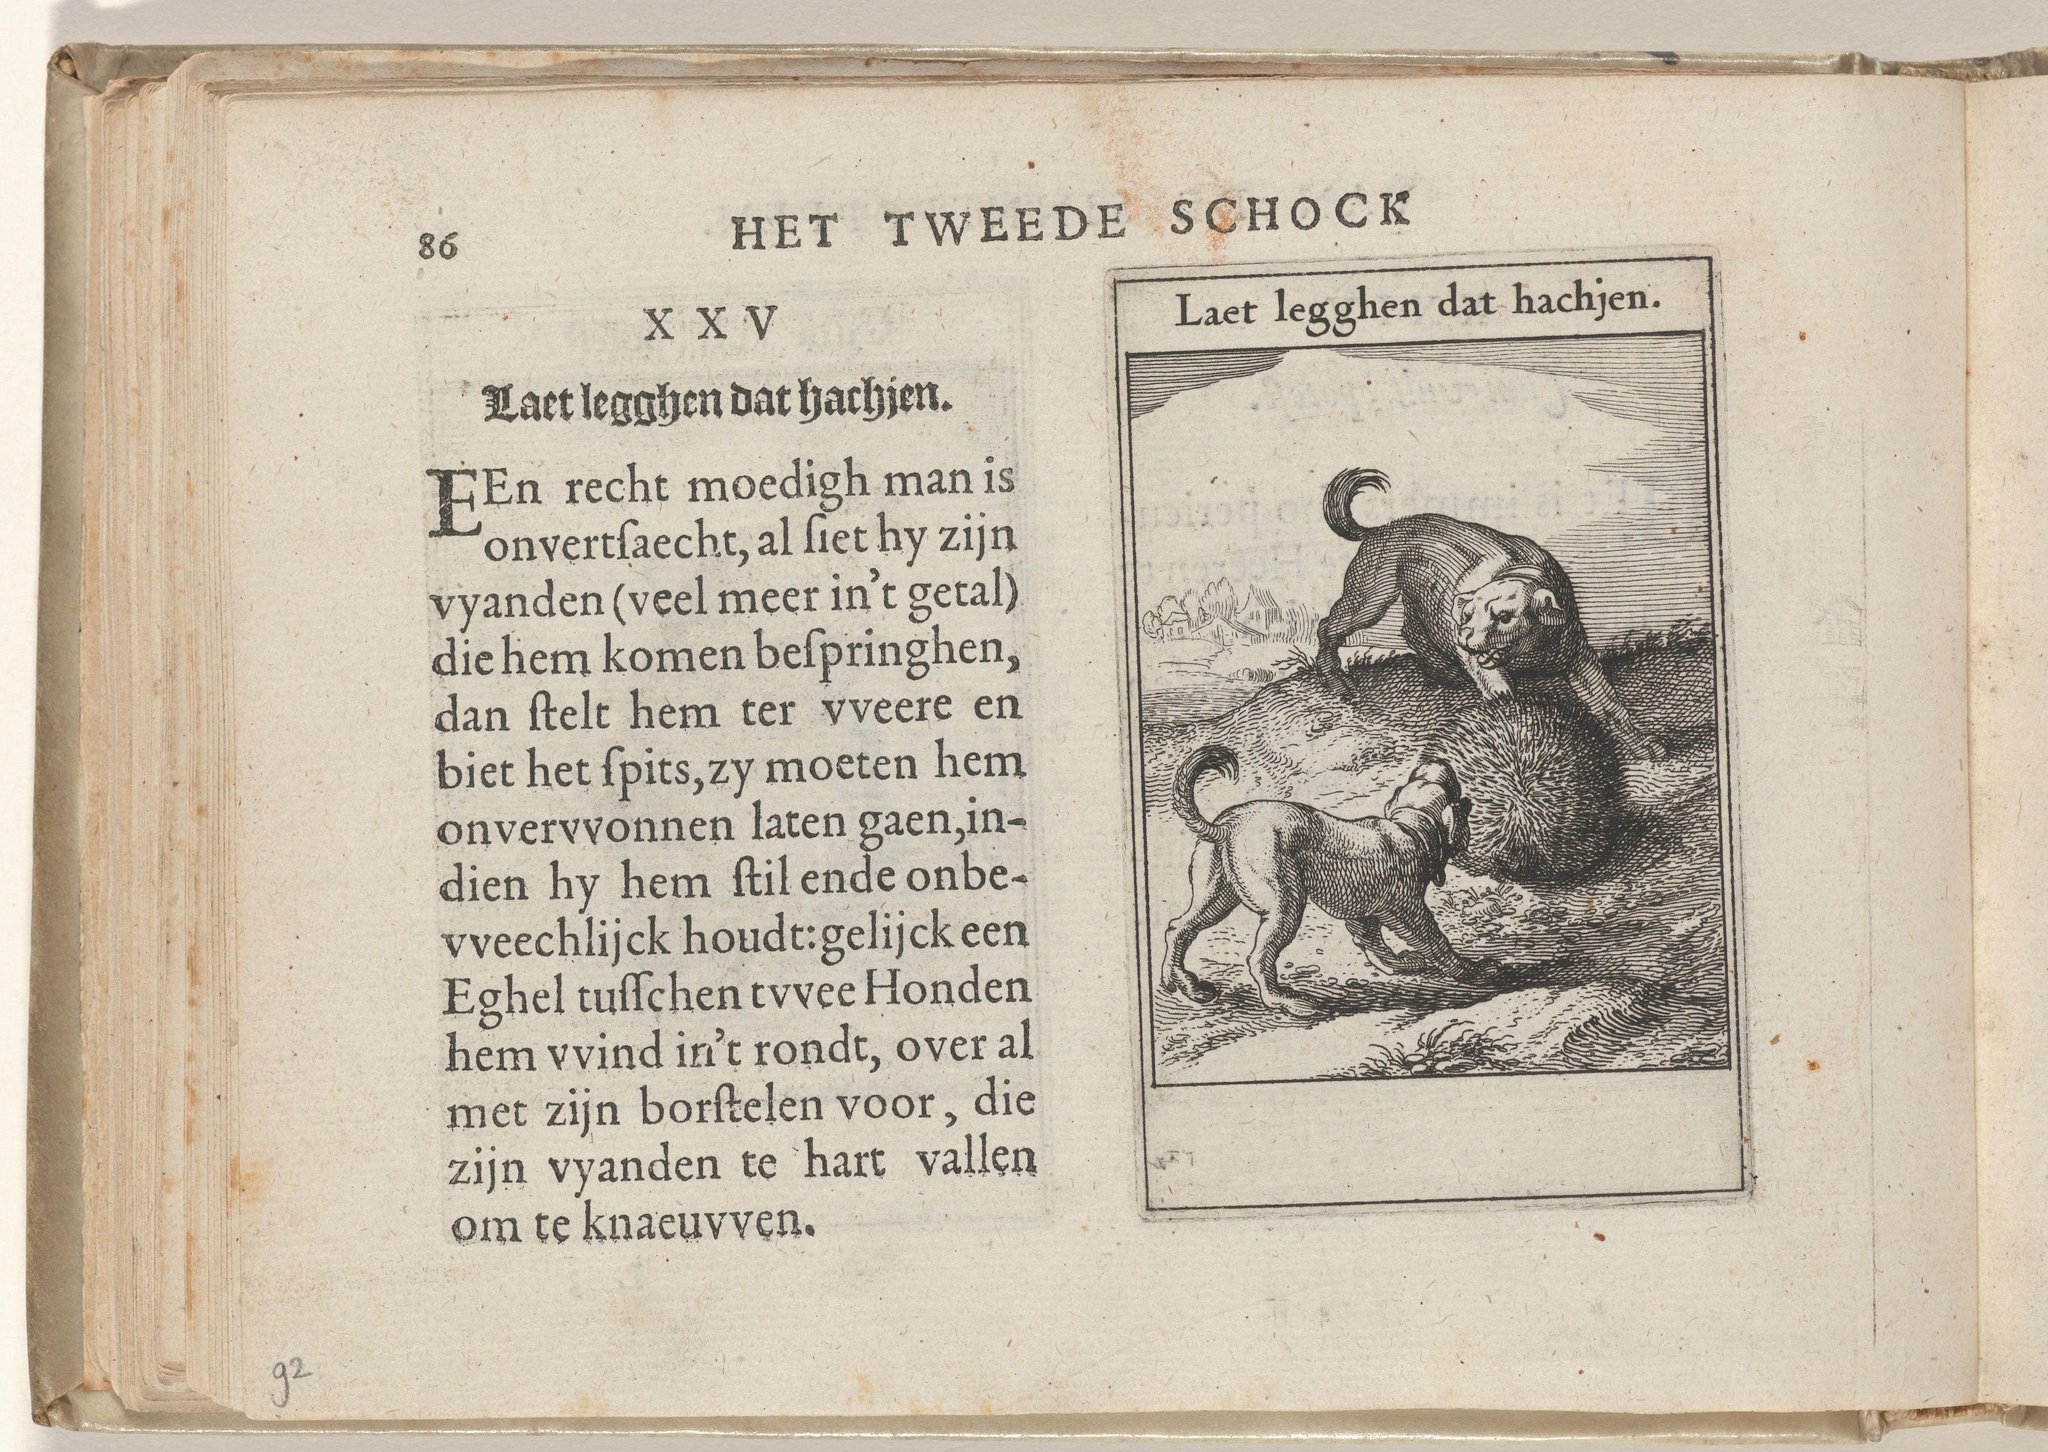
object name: album leaf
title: XXV Laet legghen dat hachjen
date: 1614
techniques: engraving, printing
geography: amsterdam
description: XXV Laet legghen dat hachjen. Tweede schok. Onderdeel van 'Sinnepoppen', R. Visscher, 1614.